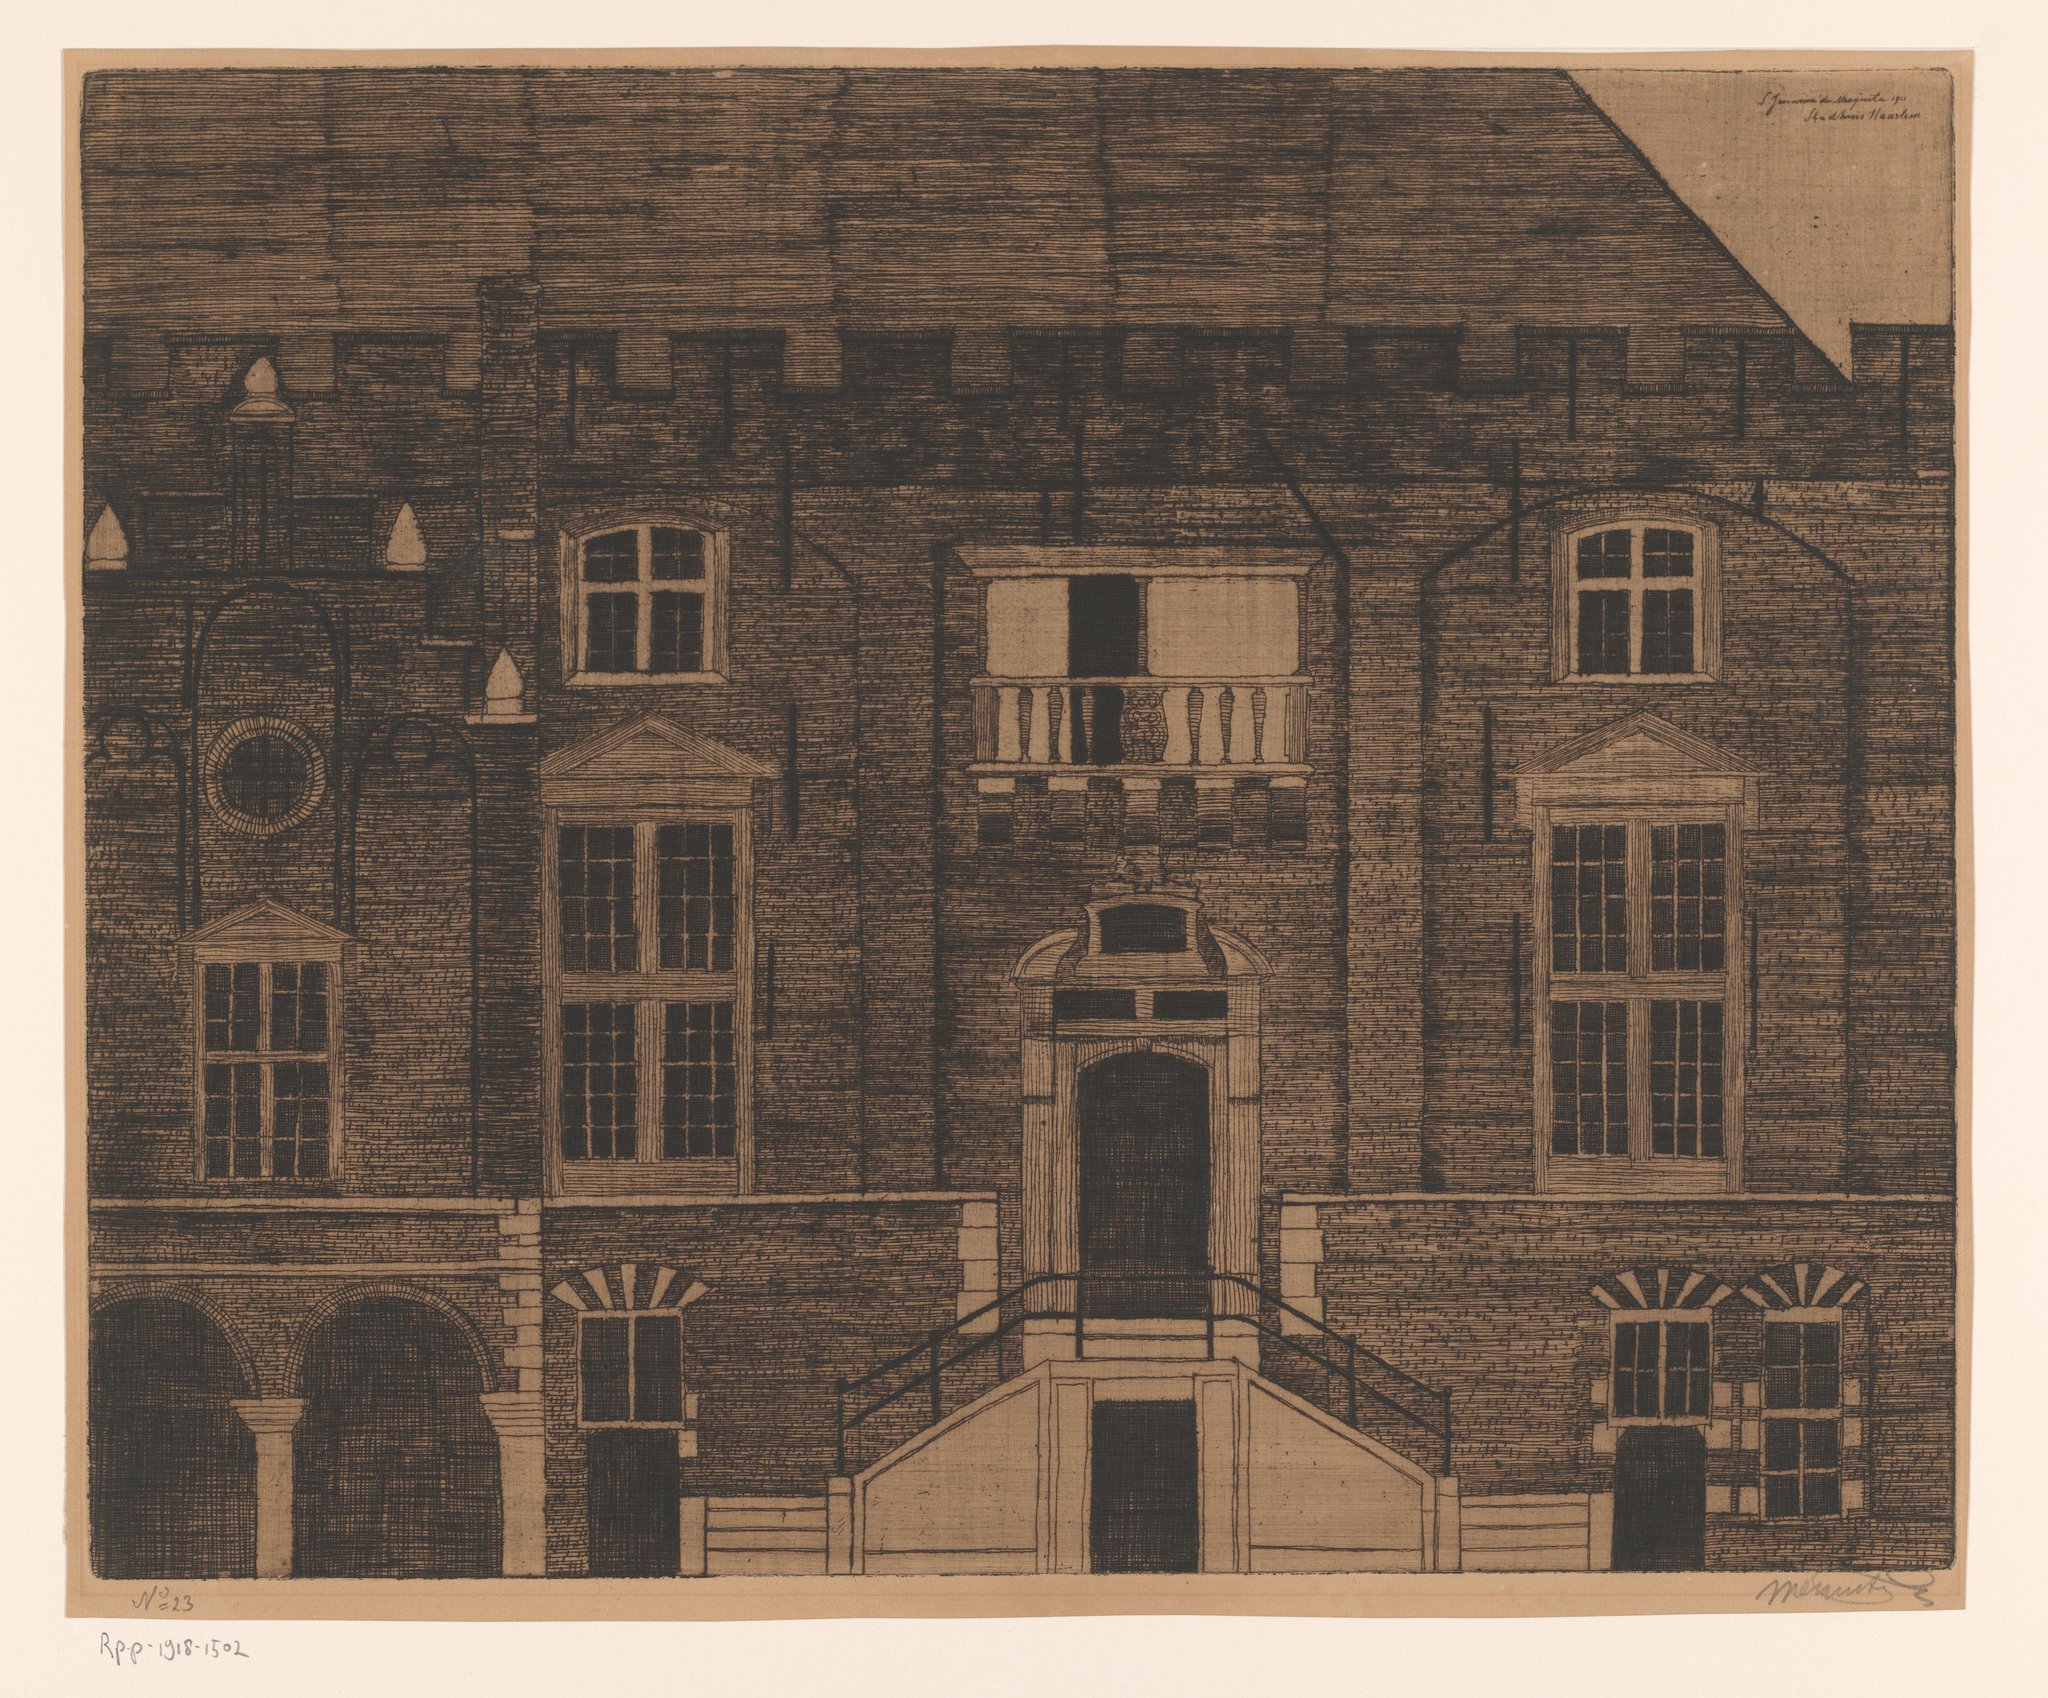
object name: print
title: Stadhuis Haarlem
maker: samuel jessurun de mesquita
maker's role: draughtsman, print maker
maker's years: 1868-1944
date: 1911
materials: paper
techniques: drypoint, etching, intaglio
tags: townhall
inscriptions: date